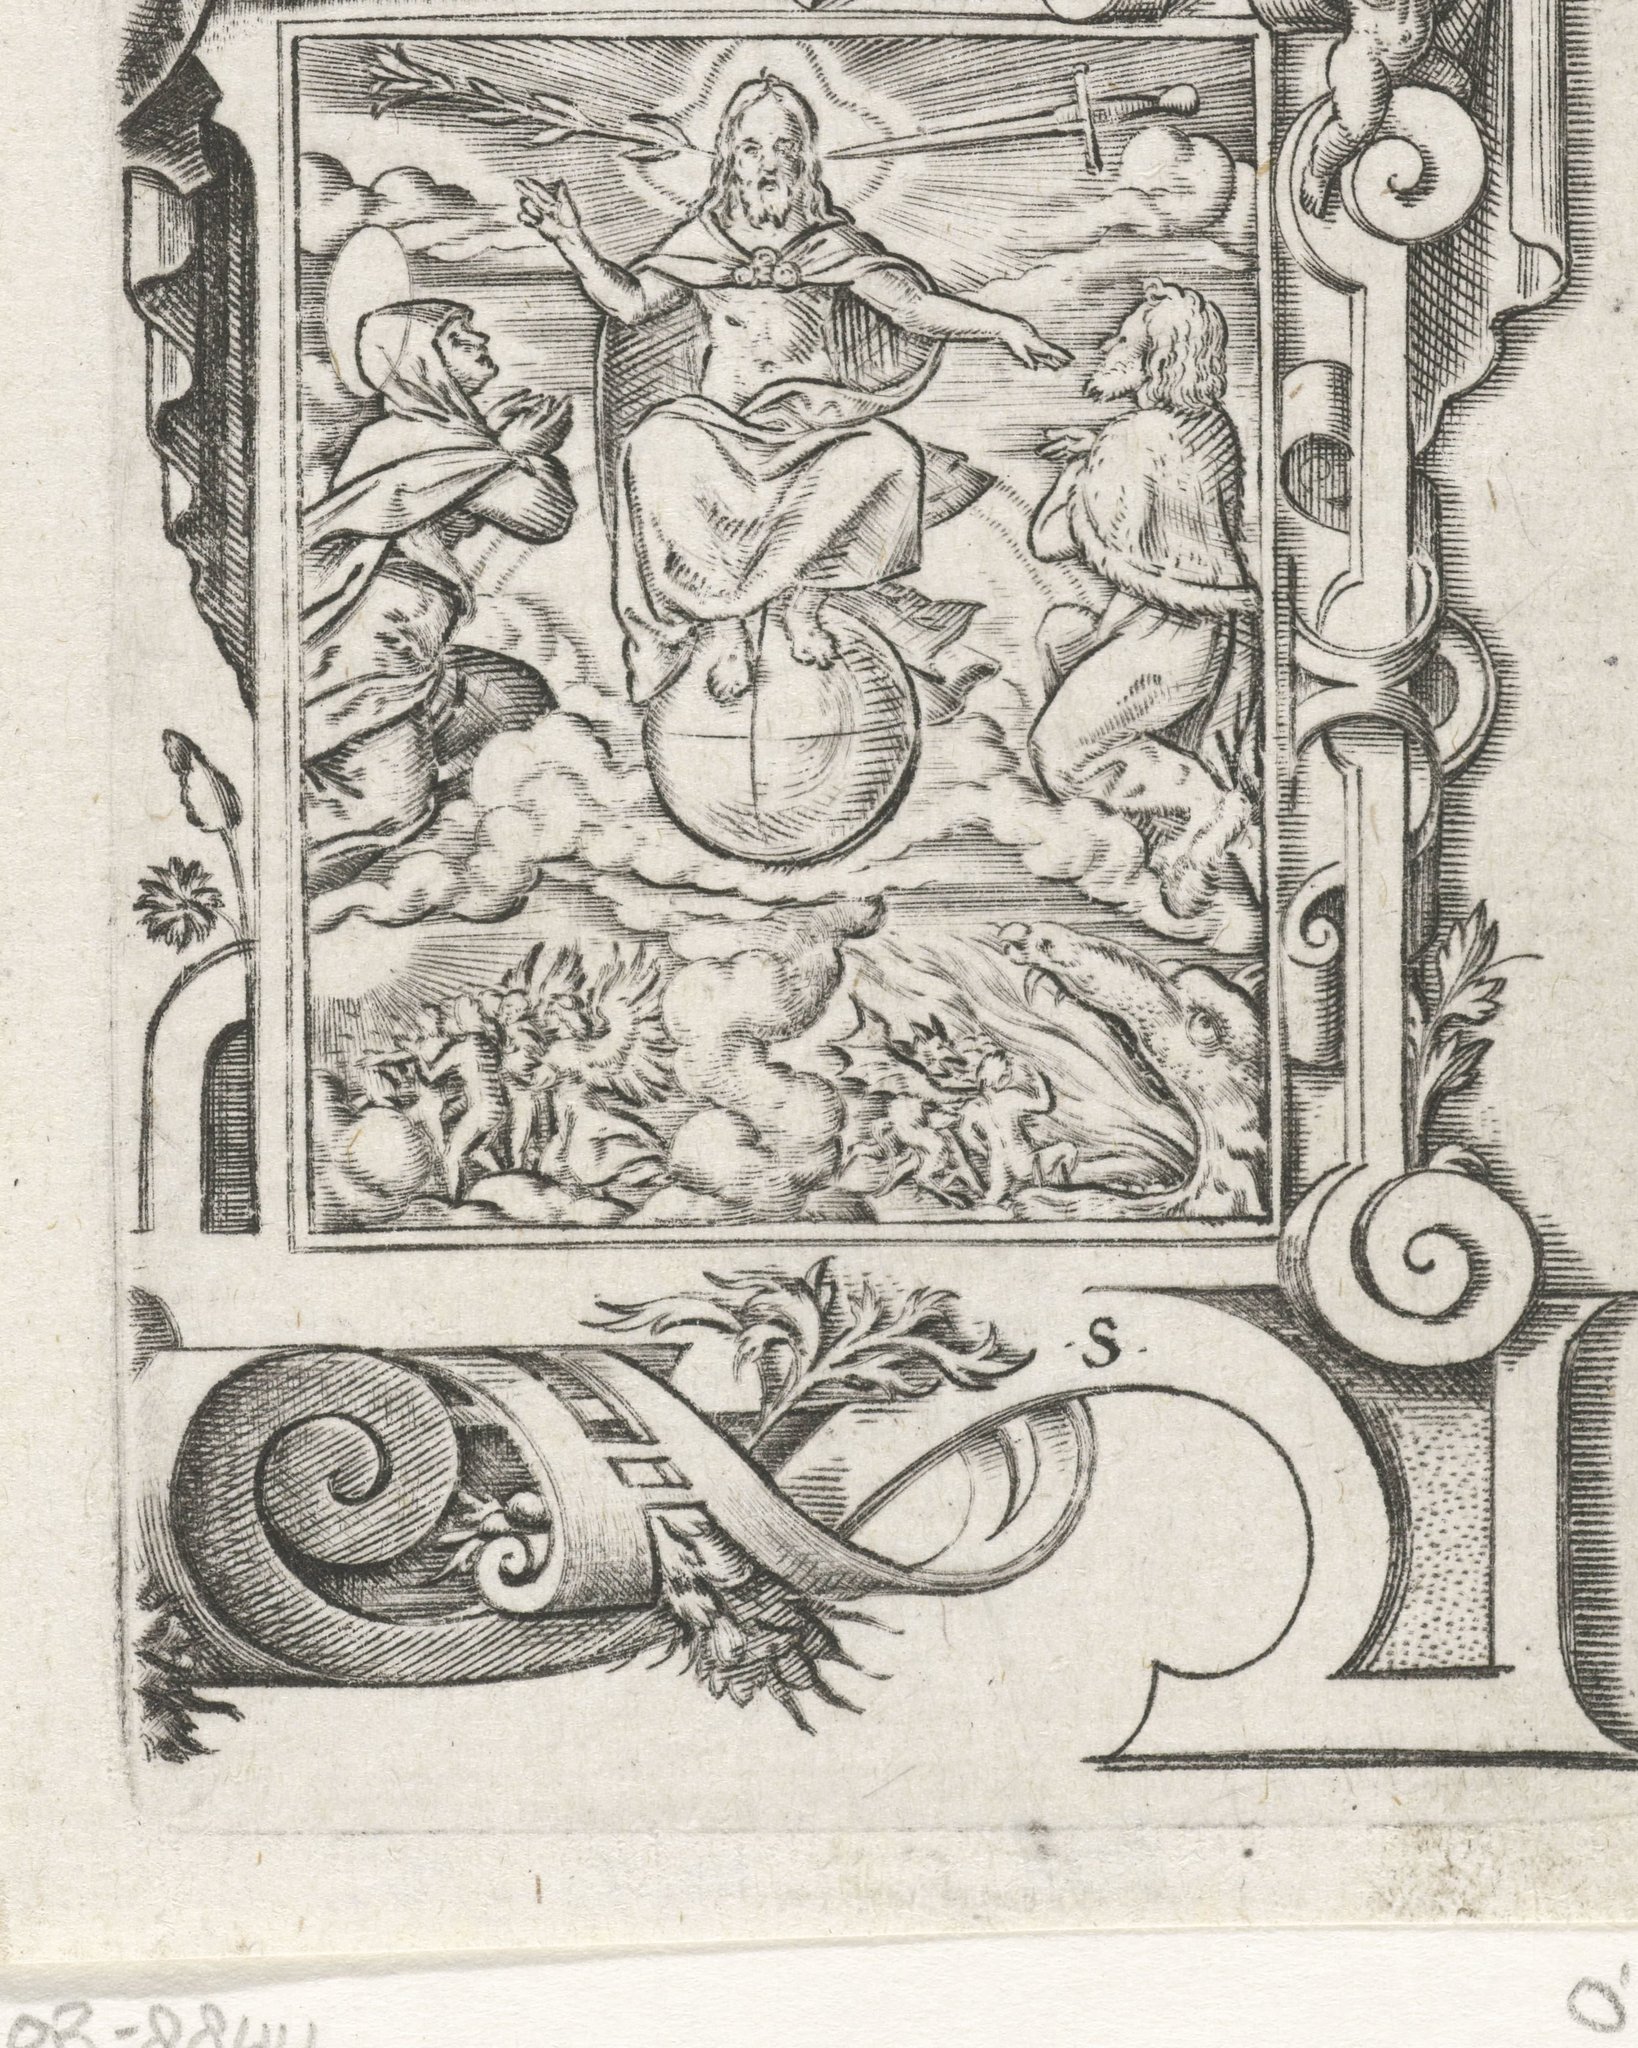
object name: print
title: Het Laatste Oordeel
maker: virgilius solis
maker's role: draughtsman, print maker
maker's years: 1514-1562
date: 1524-1562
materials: paper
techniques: engraving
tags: last judgement